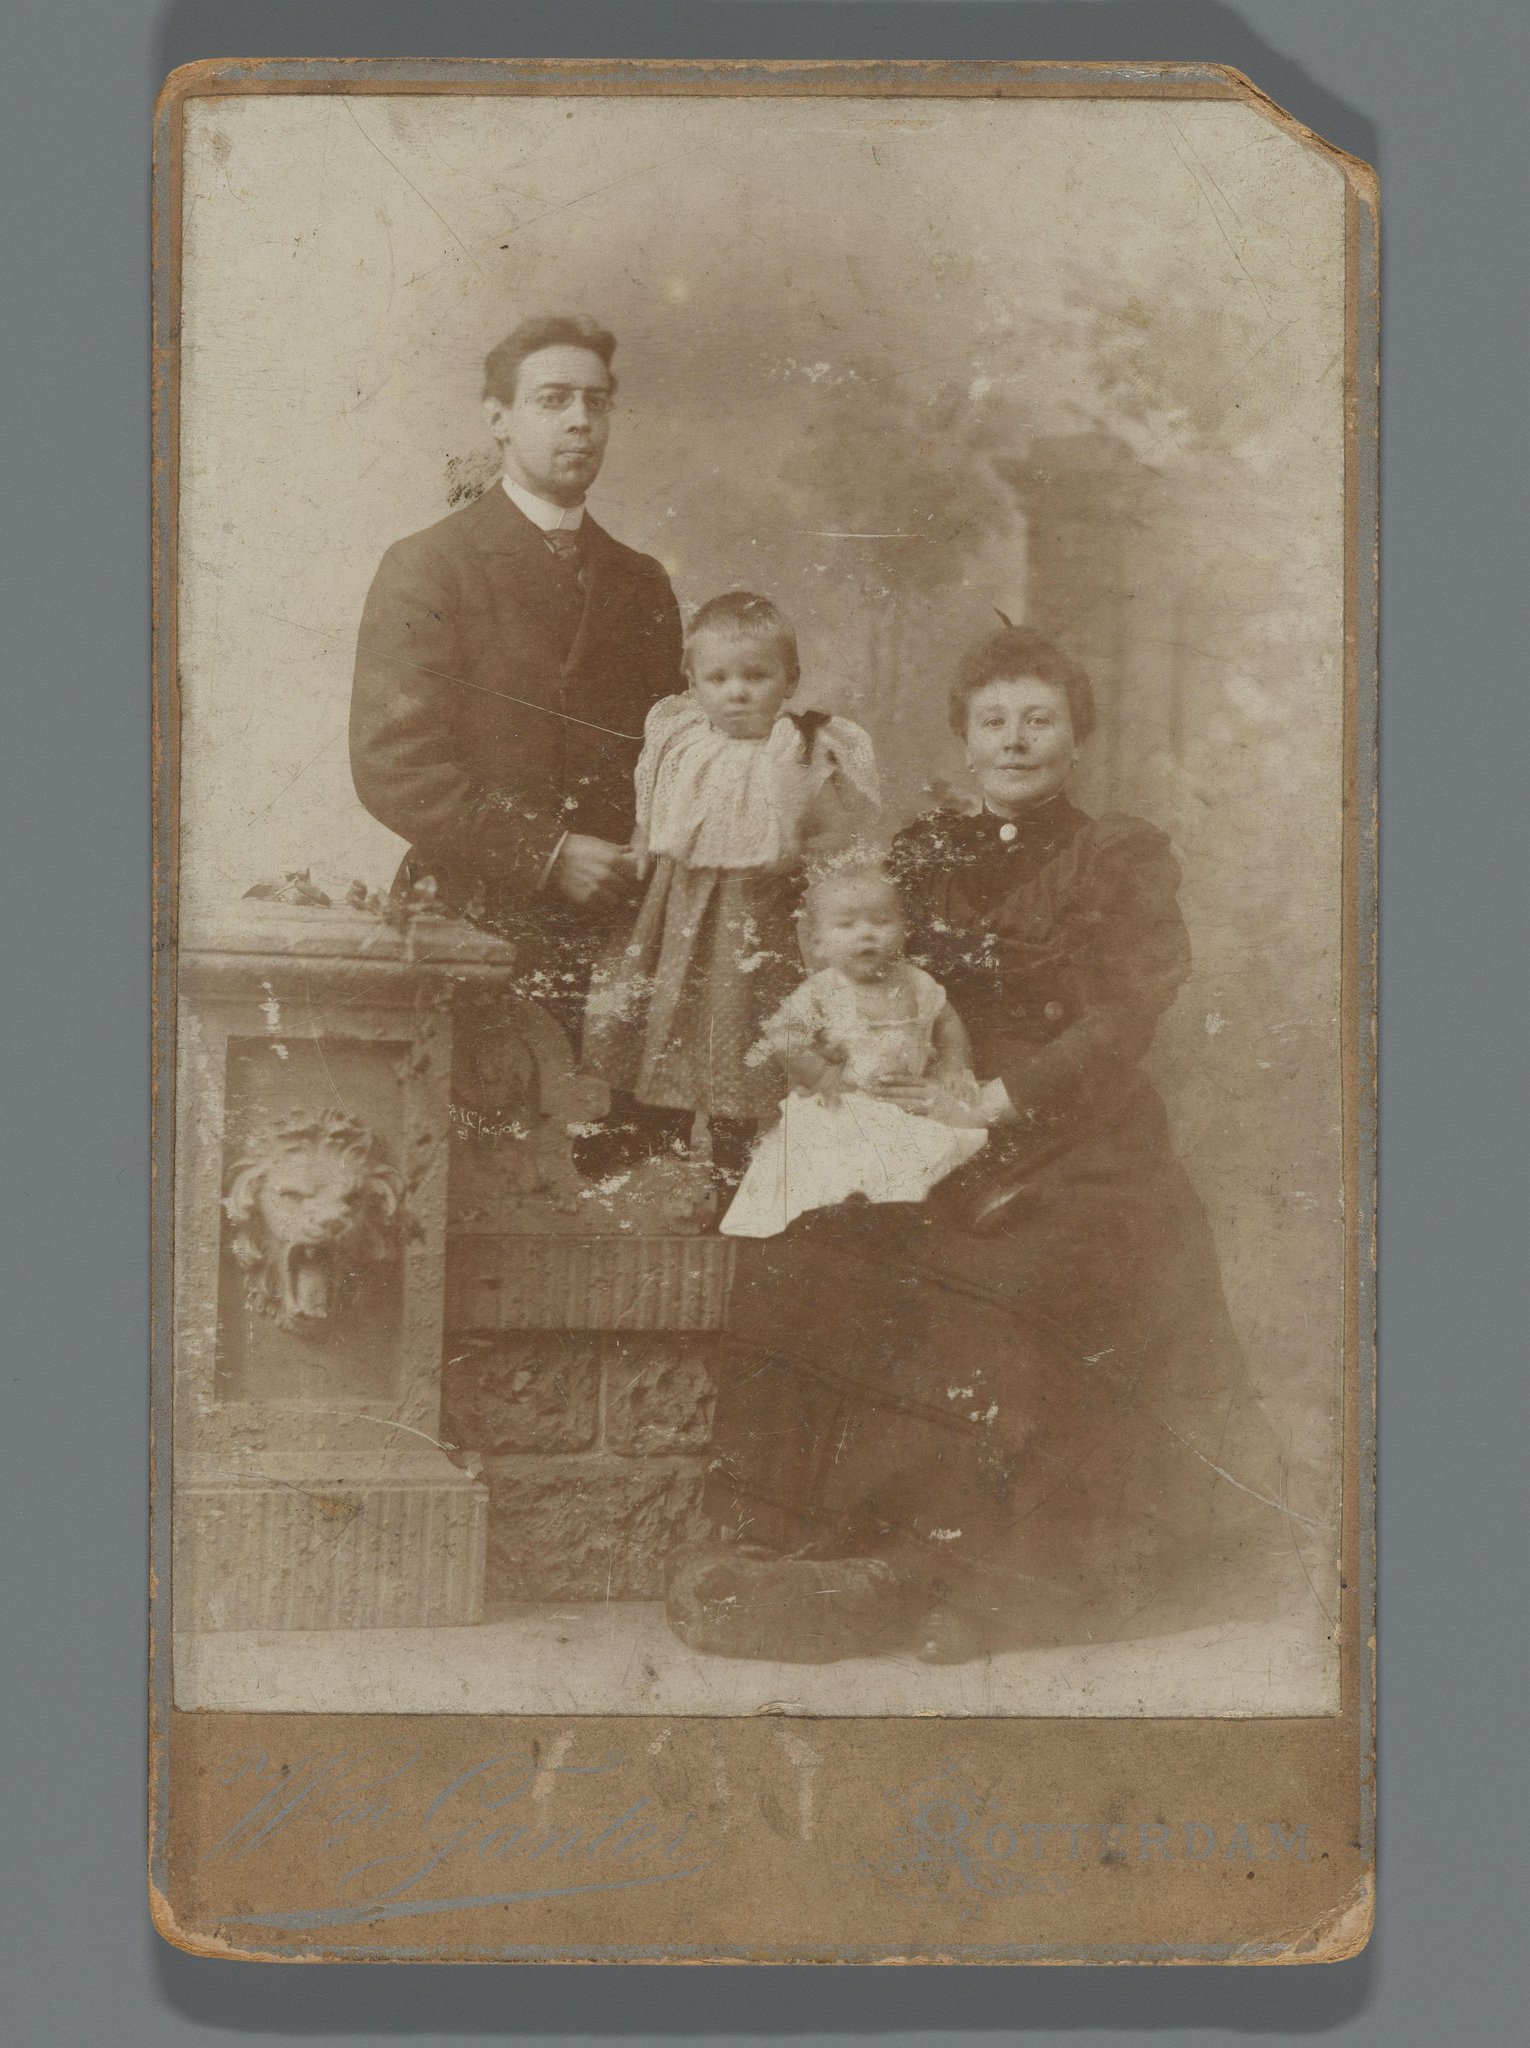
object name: cabinet photograph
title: Groepsportret van een onbekend echtpaar met twee kinderen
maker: willem ganter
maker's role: fotograaf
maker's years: 1849-1908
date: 1892-1899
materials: paper, cardboard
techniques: collodion silver print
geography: rotterdam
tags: anonymous historical persons portrayed in a group, in a group-portrait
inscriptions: address: ‘120/ Jonkerfransstraat/ Rotterdam.’